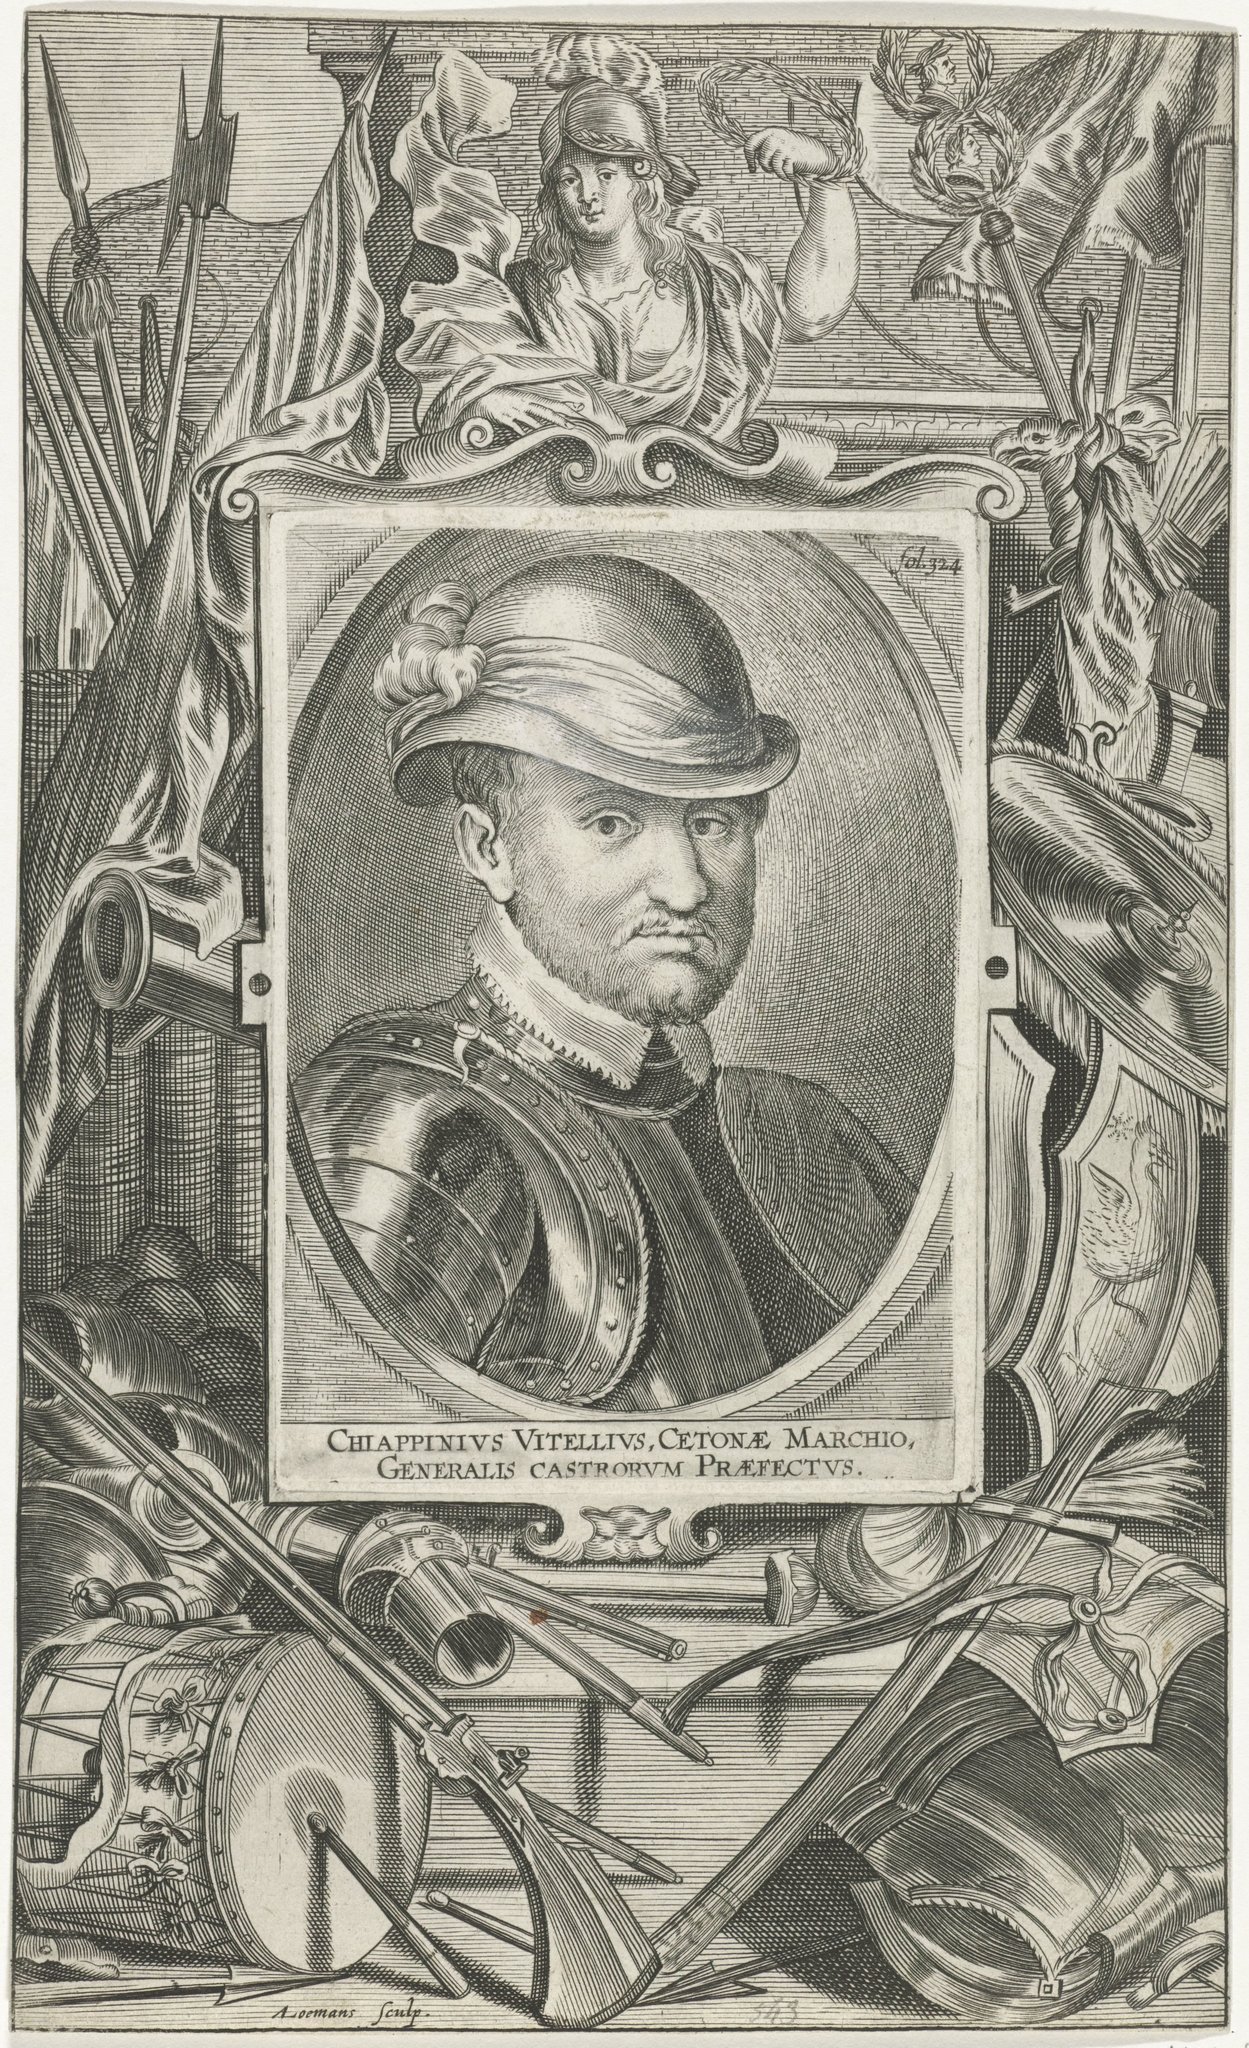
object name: print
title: Portret van Giovan Luigi Vitelli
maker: arnold loemans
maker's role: print maker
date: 1632-1661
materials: paper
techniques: engraving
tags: weapons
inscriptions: collector's mark: Lugt 2228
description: Portret van Giovan Luigi 'Chiappino' Vitelli, markies van Cetona en generaal in het Spaanse leger van Vlaanderen. Rond het portret een lijst met diverse wapens en legerattributen, bovenin Minerva met lauwerkrans. Portret rechtsboven gemerkt: fol. 324. Gedrukt van twee platen.